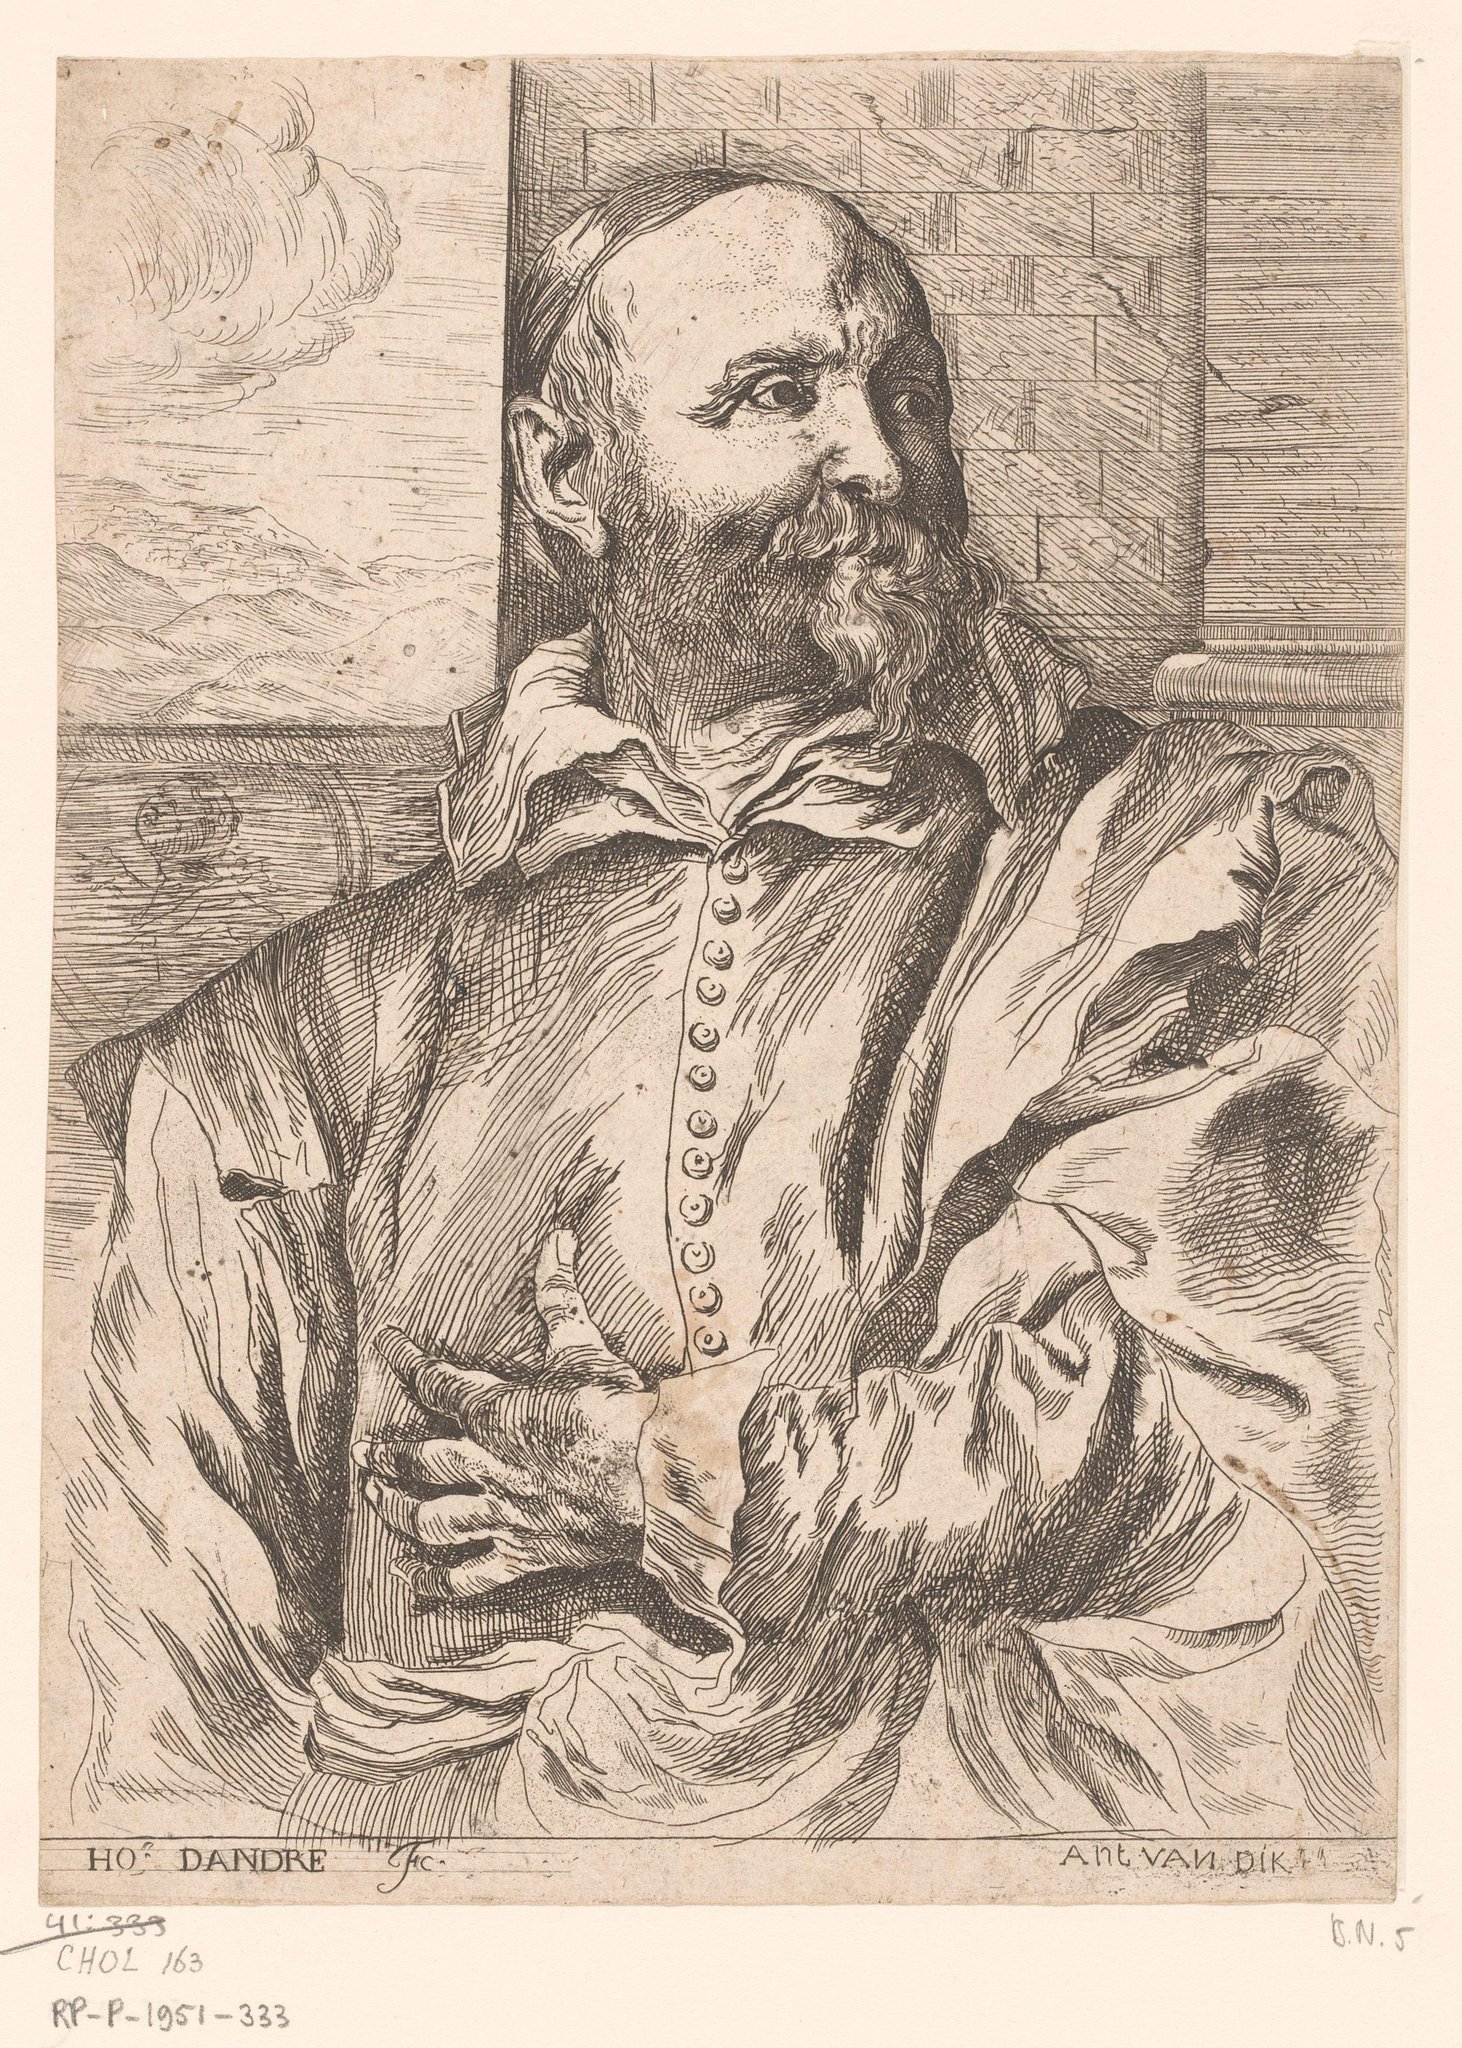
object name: print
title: Portret van Jan (I) Snellinck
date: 1710-1783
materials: paper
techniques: etching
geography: france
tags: mechelen, antwerp, painter, draughtsman, jan snellinck (i), historical persons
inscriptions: collector's mark: Lugt 2228